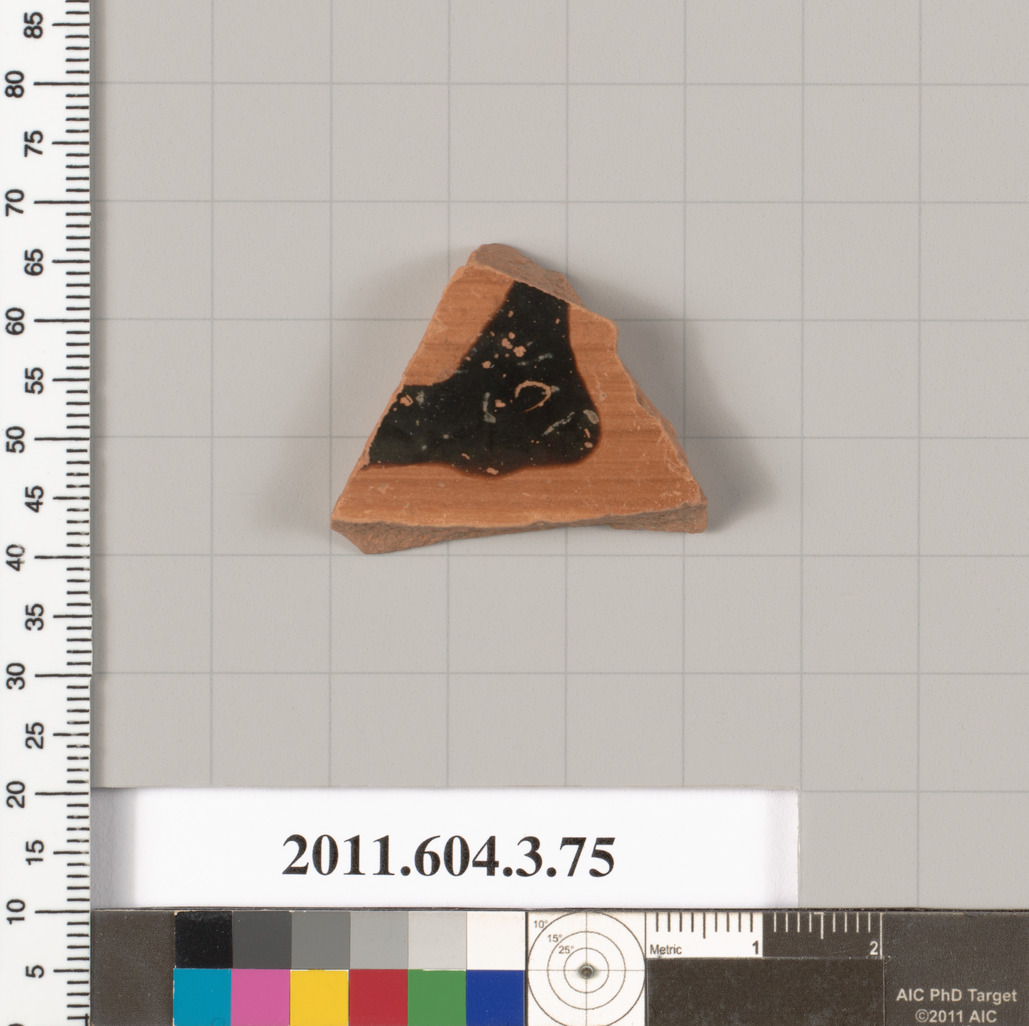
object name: amphora fragment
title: Terracotta fragment of an amphora (jar)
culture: greek, attic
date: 525-501 BCE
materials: terracotta